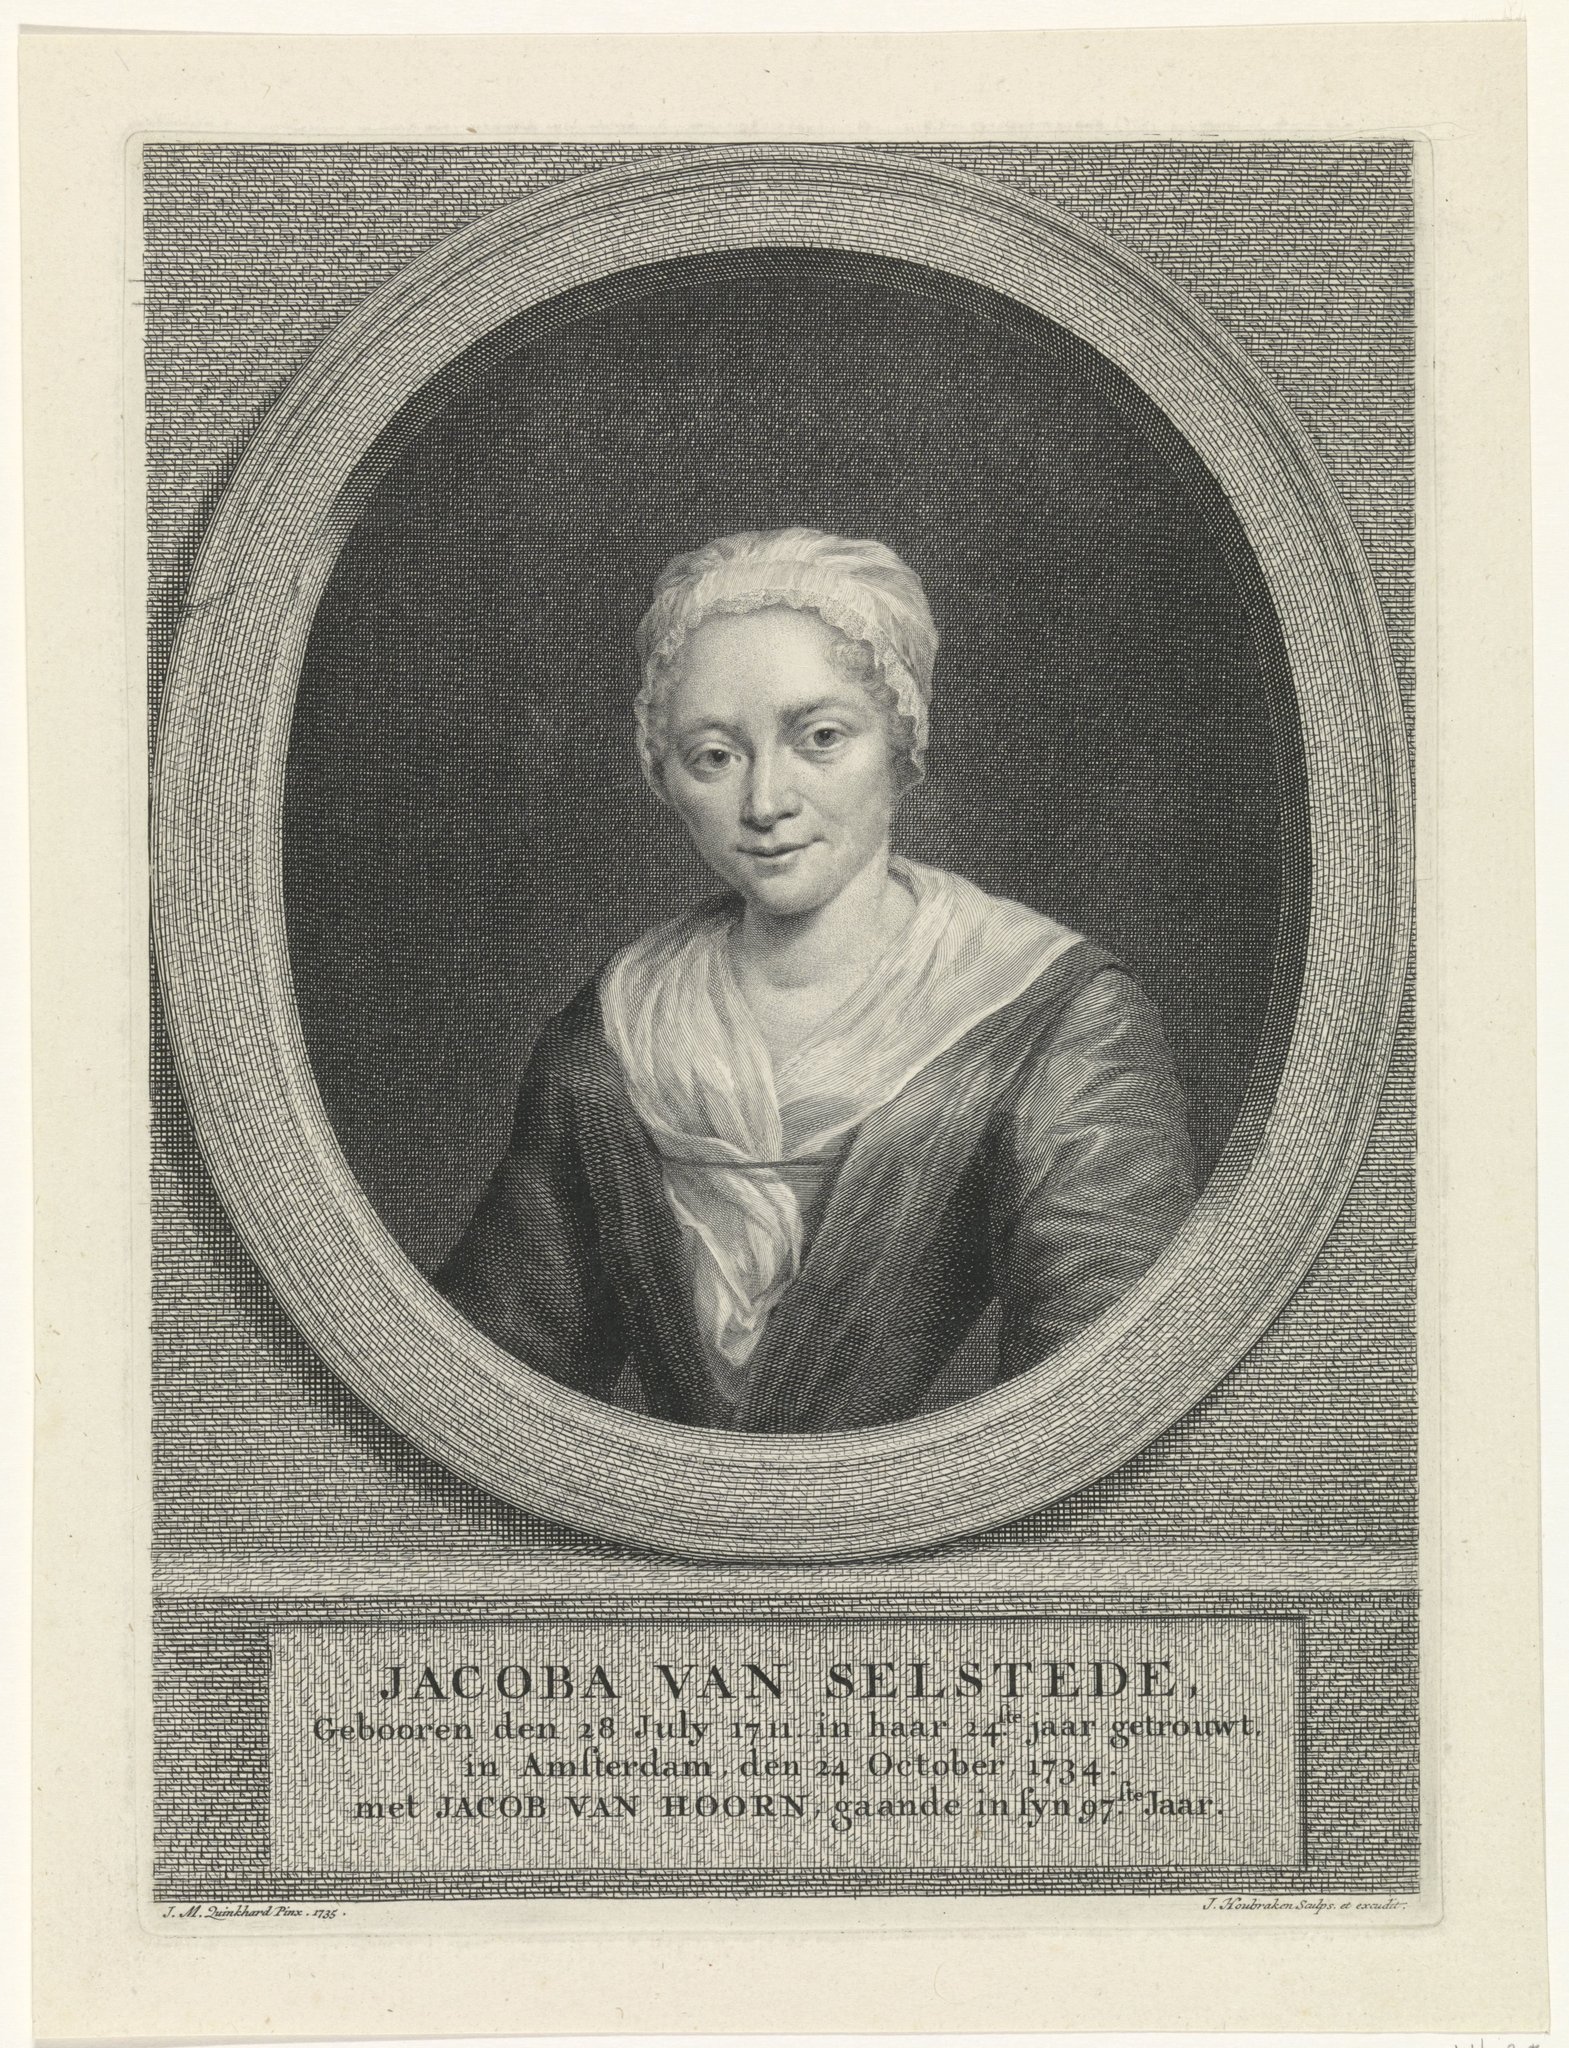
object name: print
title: Jacoba van Selstede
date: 1735-1736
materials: paper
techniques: engraving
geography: amsterdam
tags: jacoba van selstede, jacob hoorn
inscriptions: collector's mark: Lugt 240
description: Portret van Jacoba van Selstede in een ovale architectonische omlijsting. Onder het portret een plint waarop haar naam en gegevens in vier regels in het Nederlands.